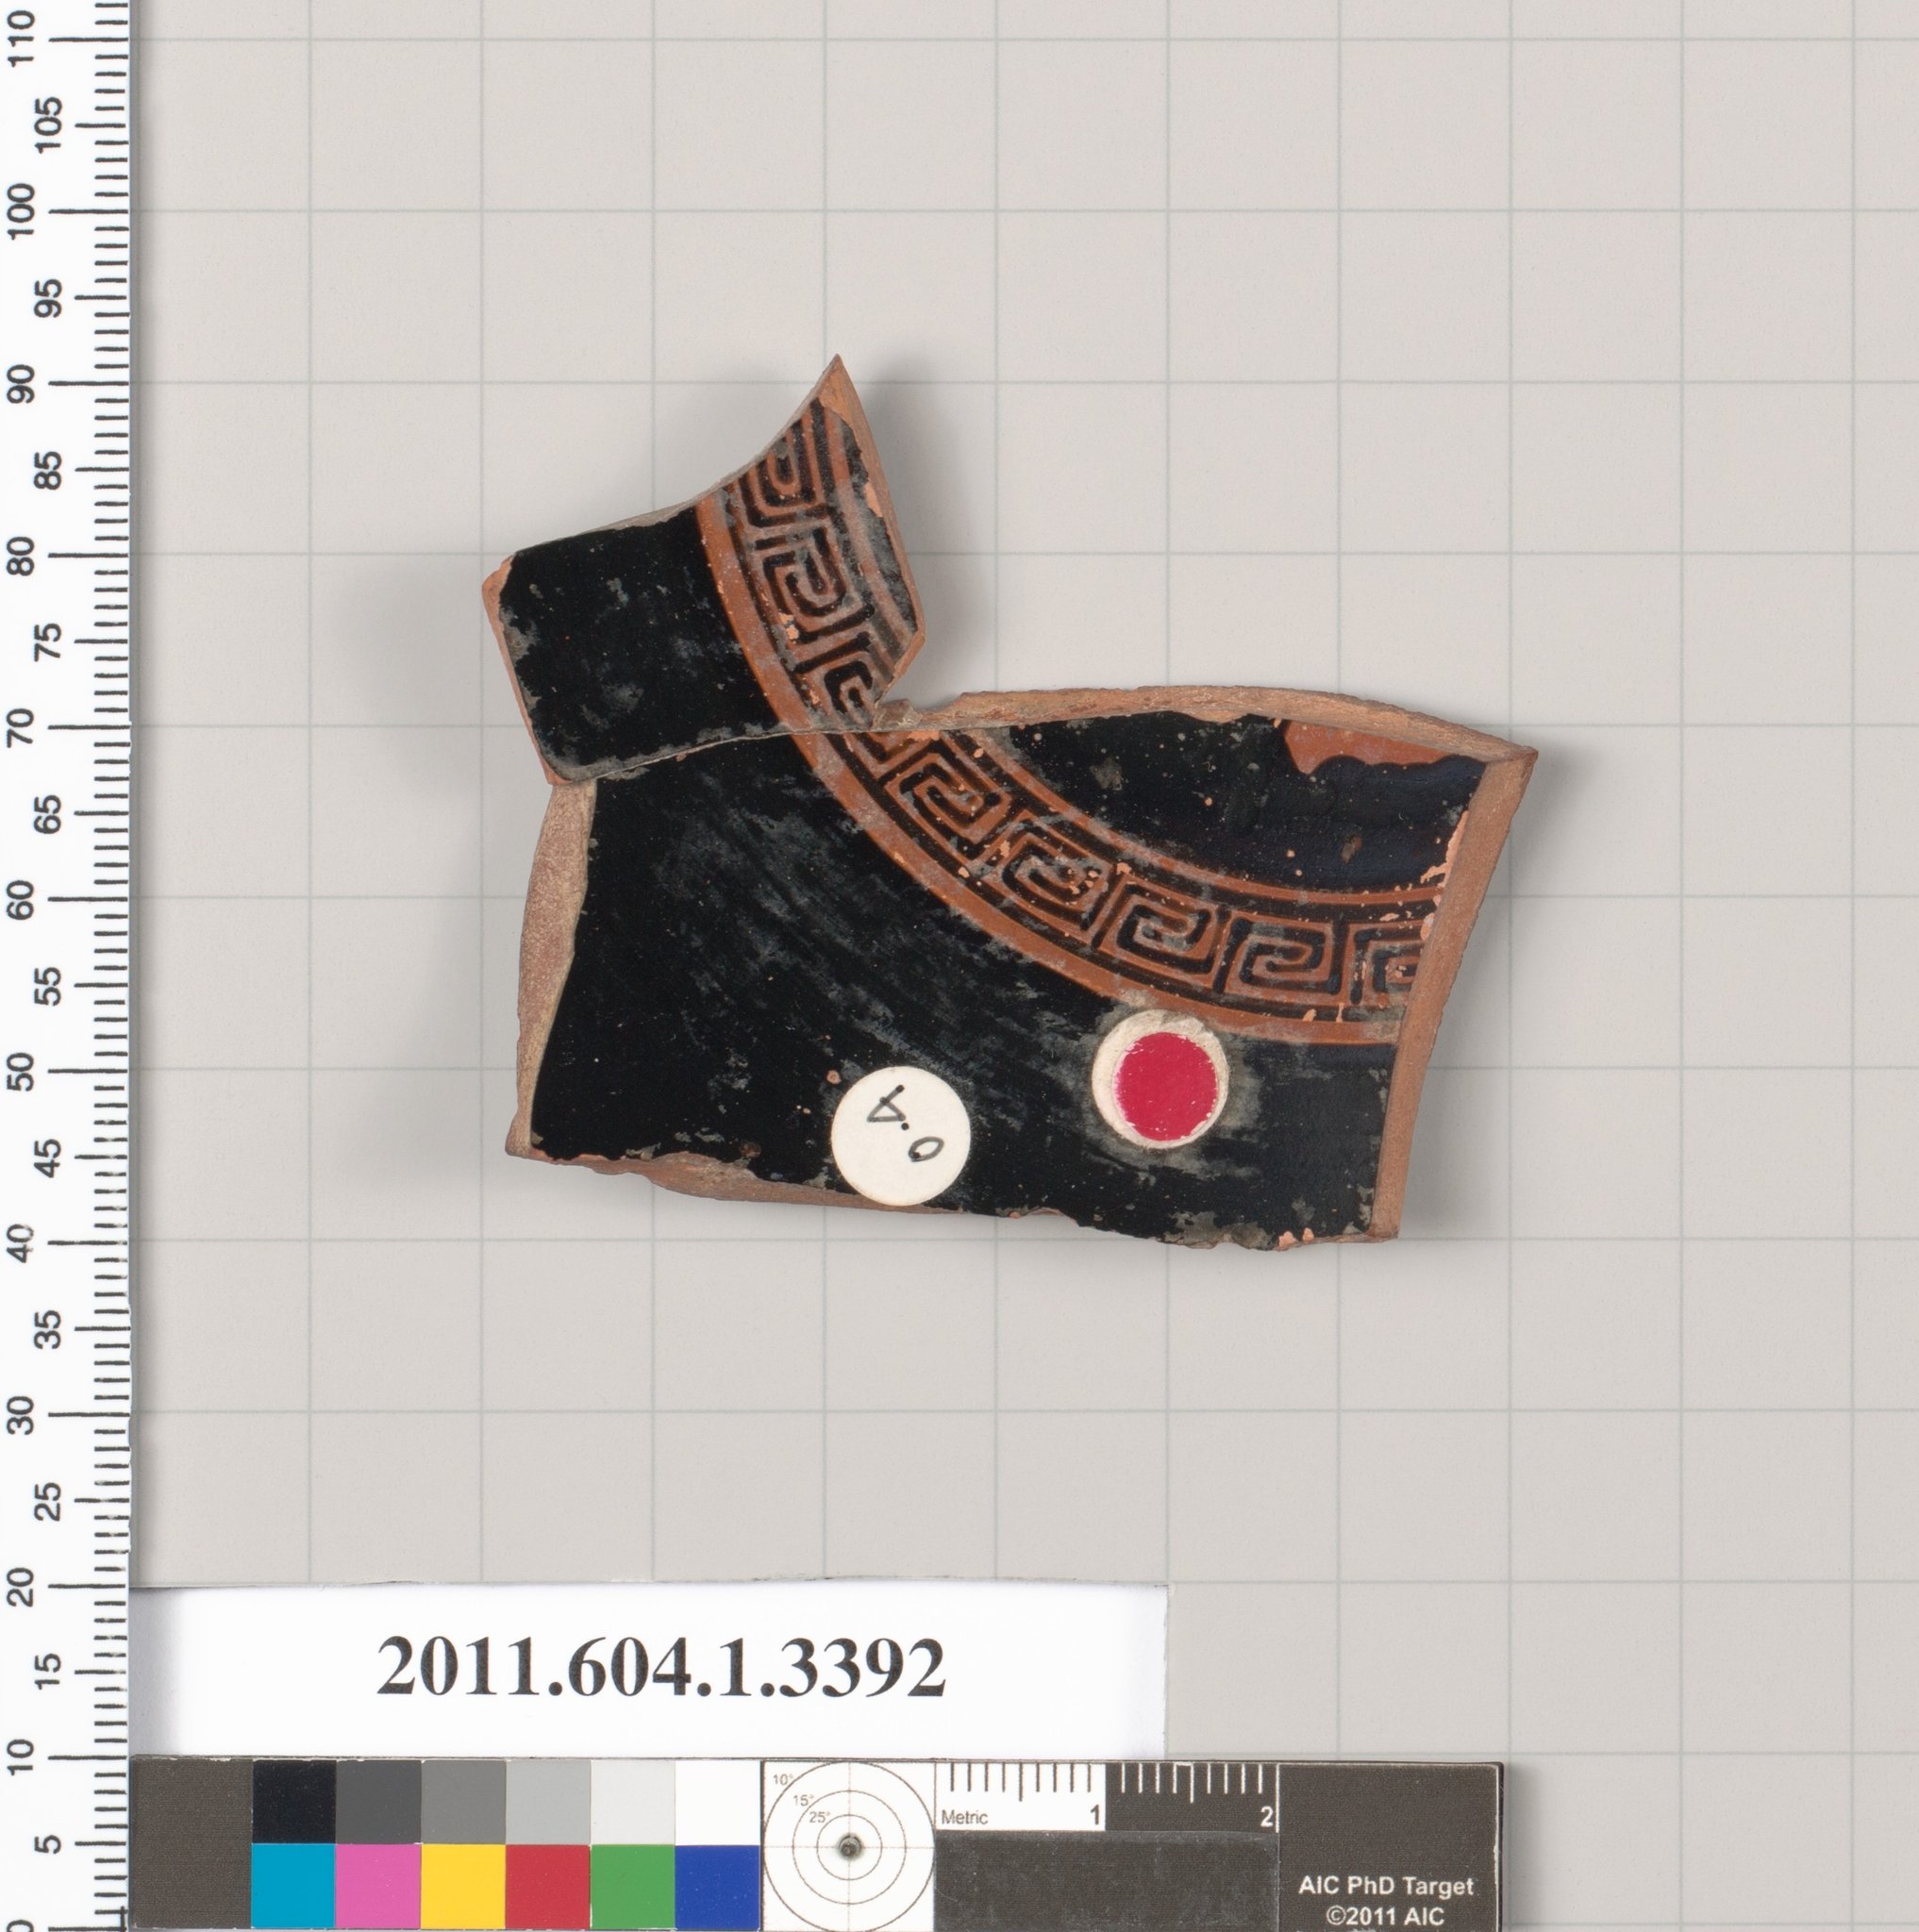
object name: kylix fragment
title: Terracotta fragment of a kylix (drinking cup)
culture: greek, attic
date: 534-468 BCE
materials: terracotta